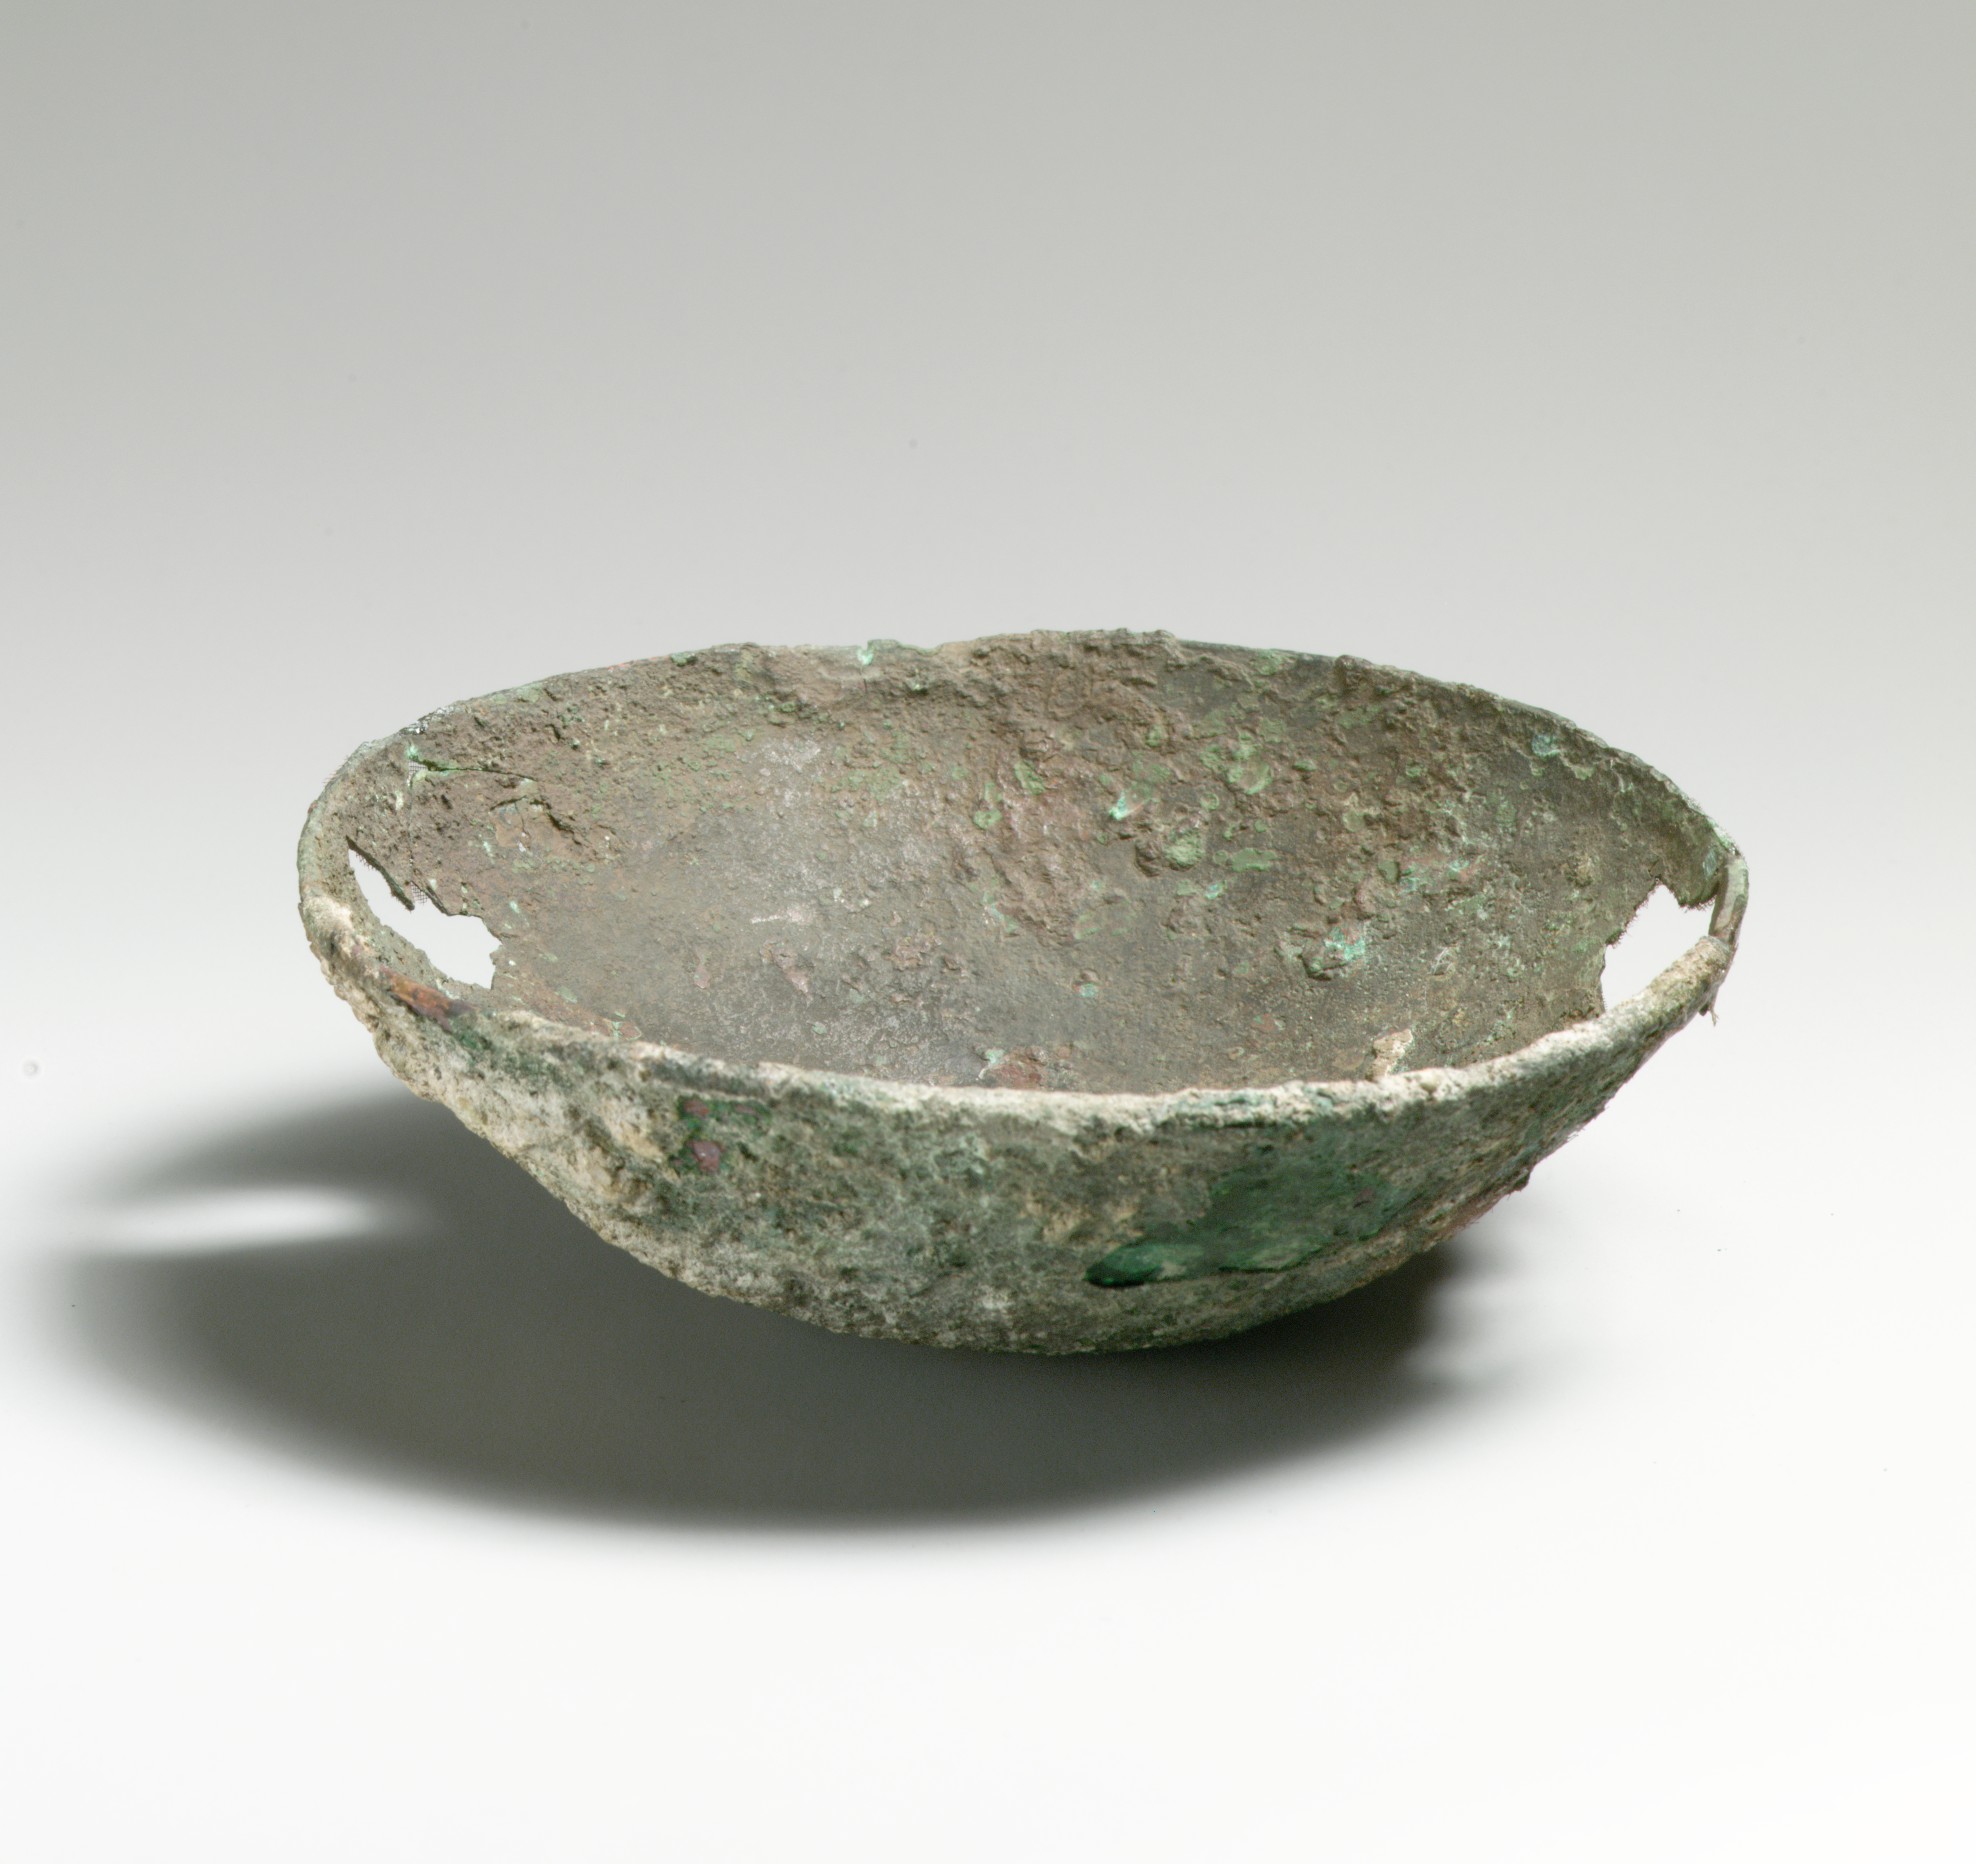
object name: bowl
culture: cypriot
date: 3900 BCE-100 CE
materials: bronze